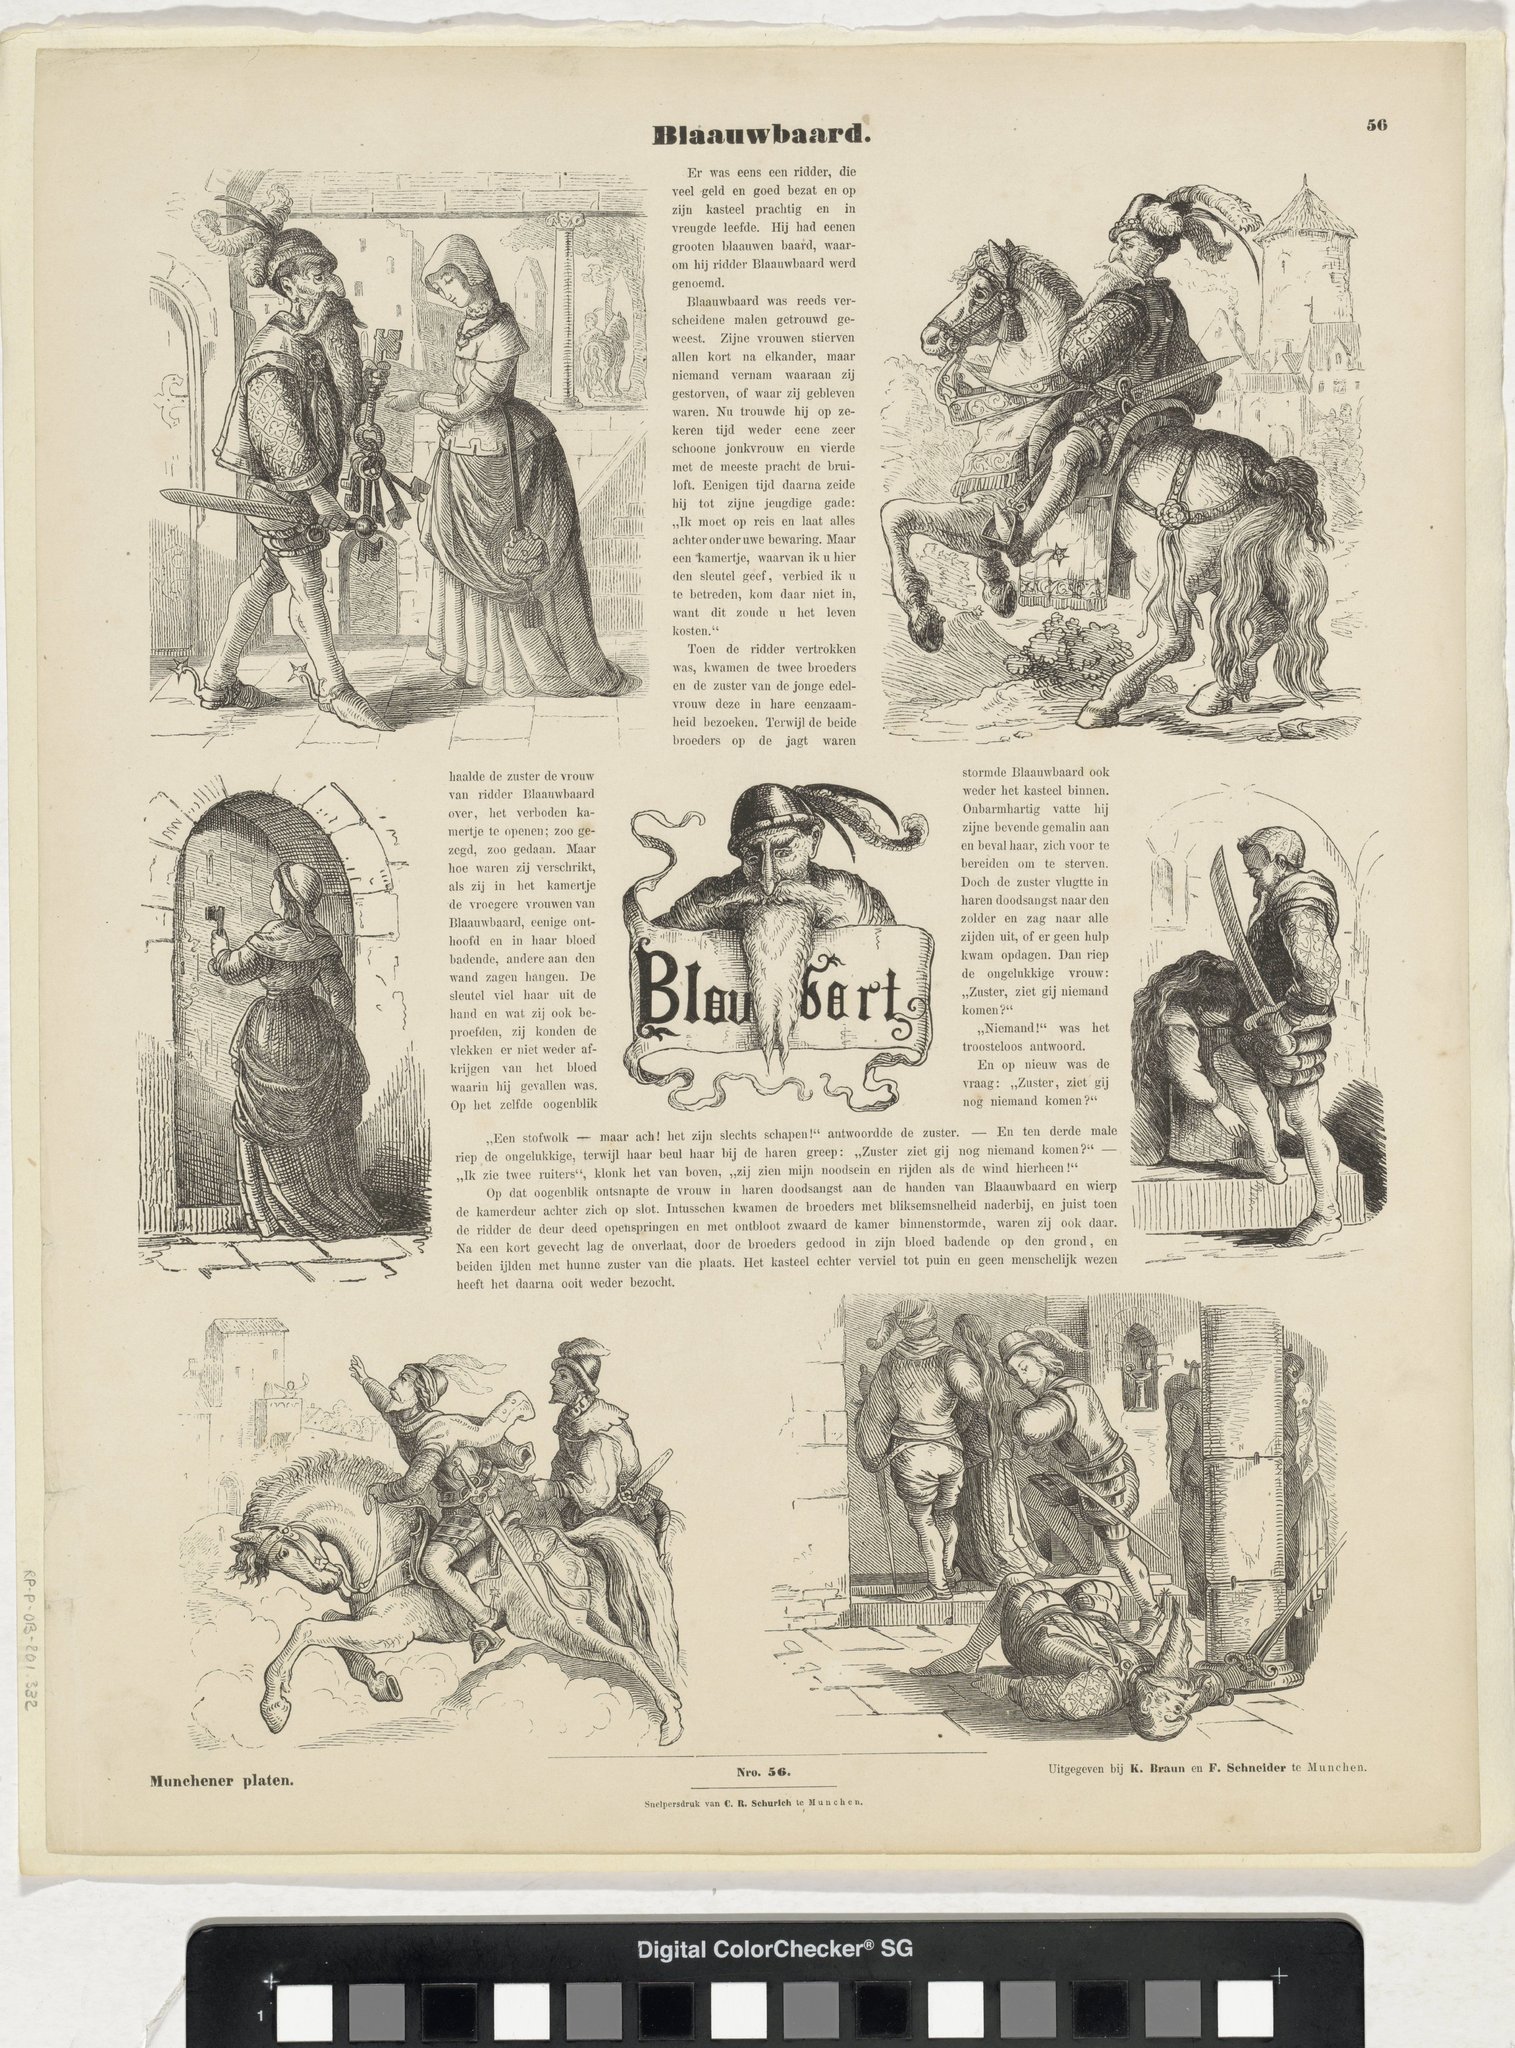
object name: print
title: Munchener platen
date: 1843-1920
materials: paper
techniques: letterpress printing, engraving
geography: munich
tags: tales and fairy tales (with title)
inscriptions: collector's mark: Lugt 2760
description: Blad met 7 voorstellingen over het sprookje van Blaauwbaard. Tekst tussen de afbeeldingen. Genummerd midden onder: Nro. 56. Genummerd rechtsboven: 56.